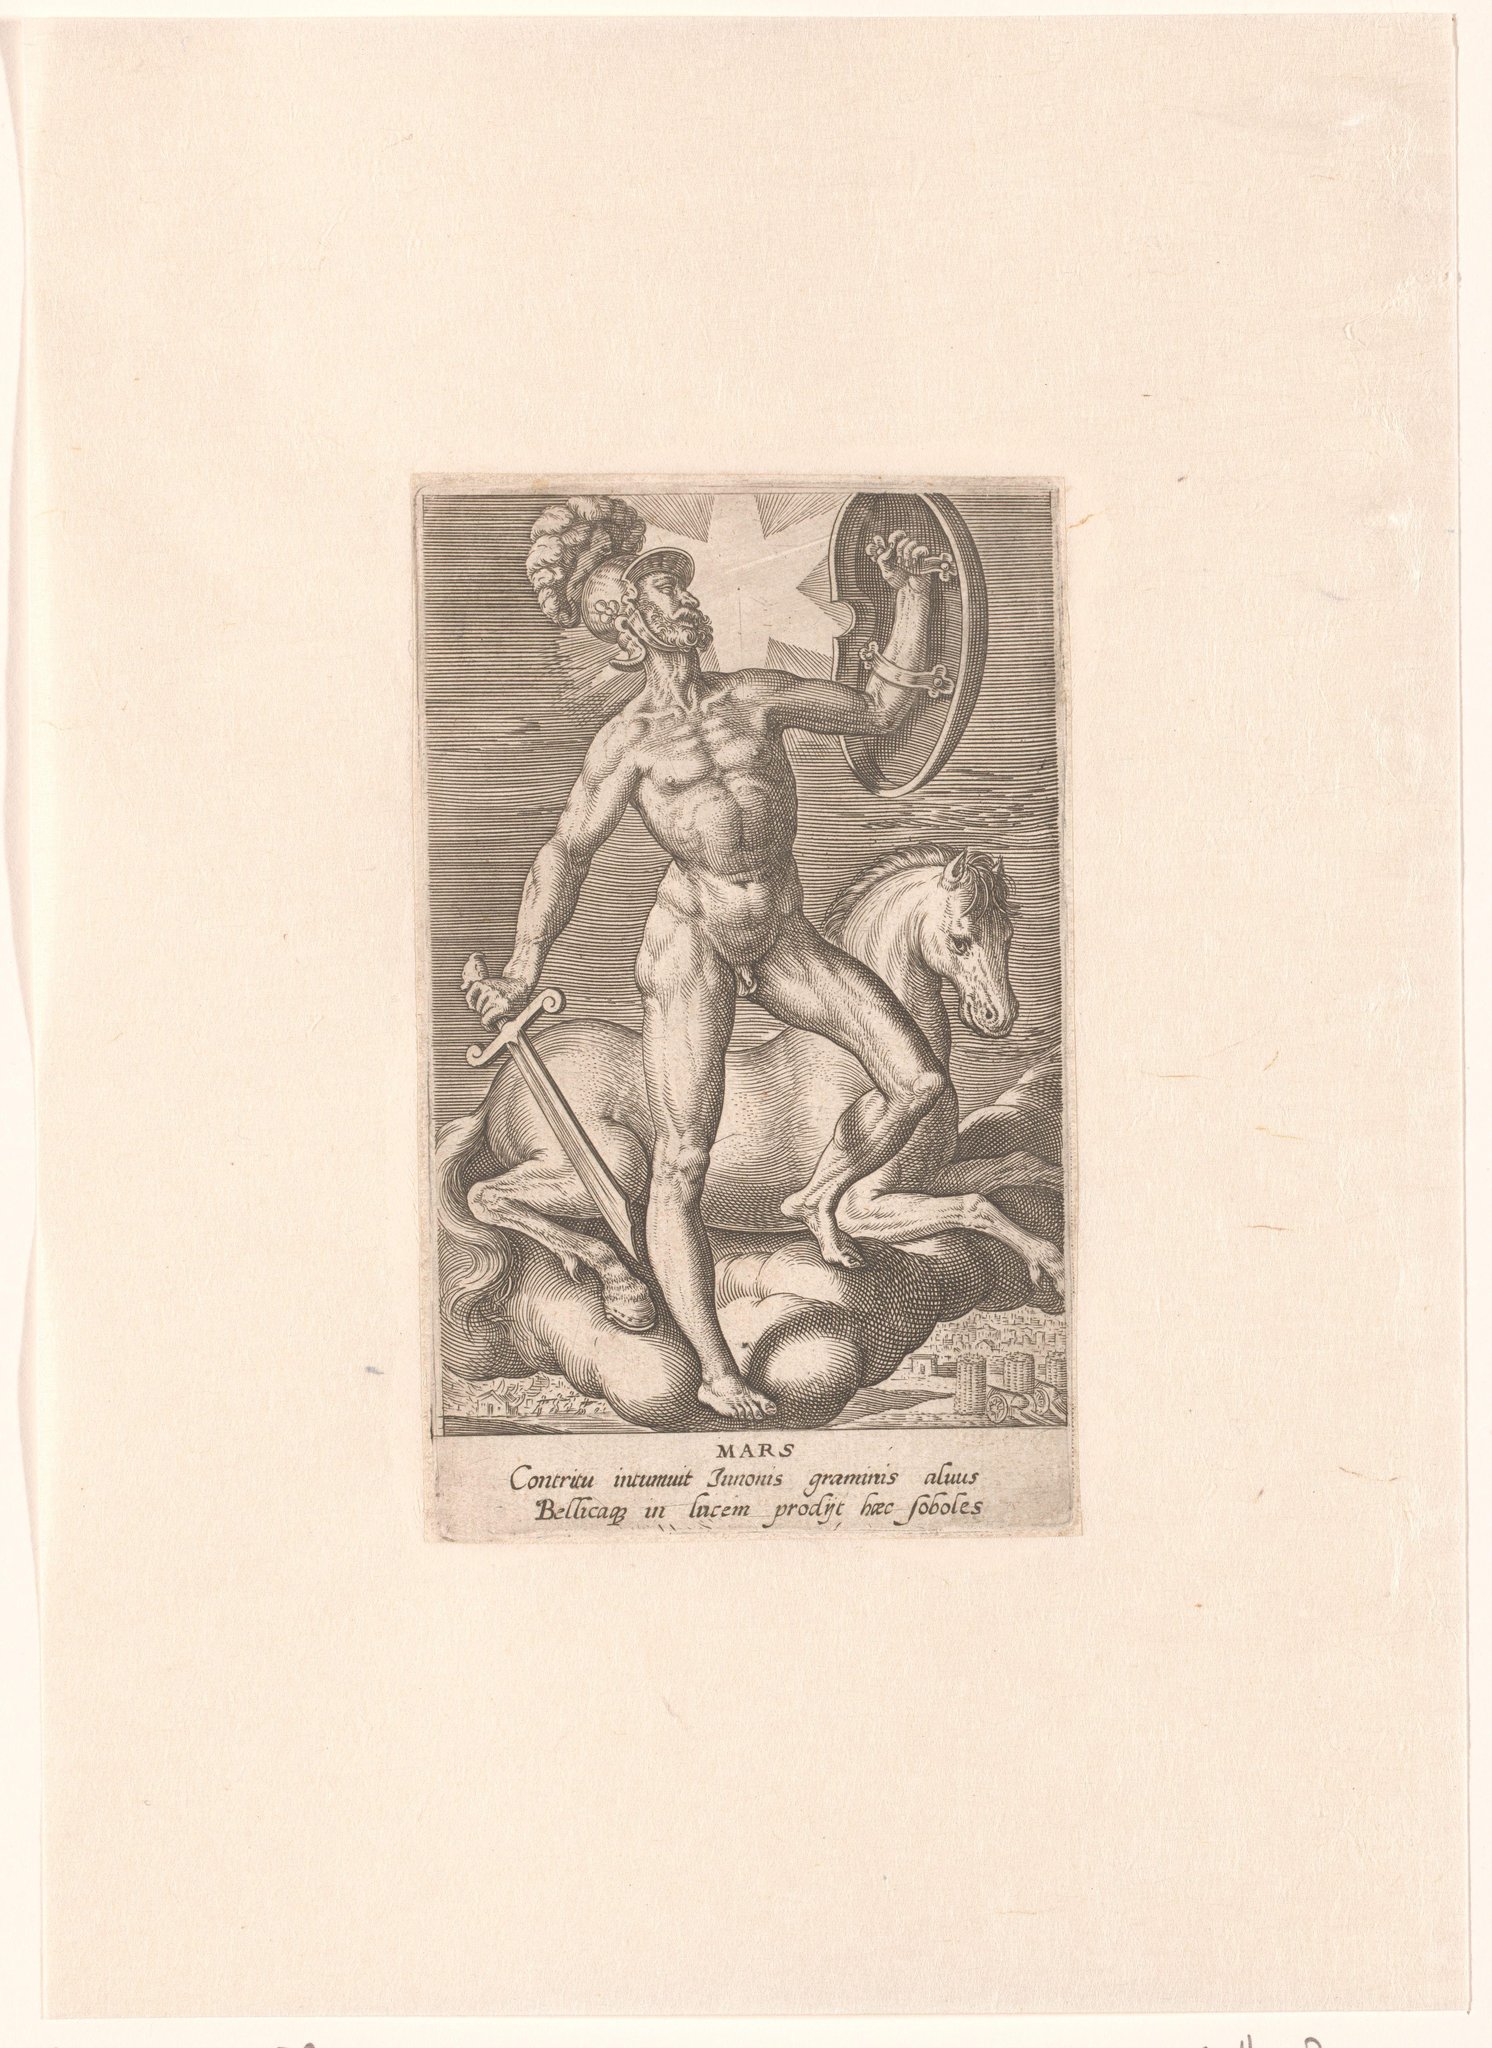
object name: print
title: Mars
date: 1581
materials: paper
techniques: engraving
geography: antwerp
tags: (story of) mars (ares)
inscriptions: collector's mark: Lugt 2228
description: Mars met zwaard en schild in zijn handen. Achter hem ligt een paard. In de ondermarge een tweeregelige Latijnse tekst.